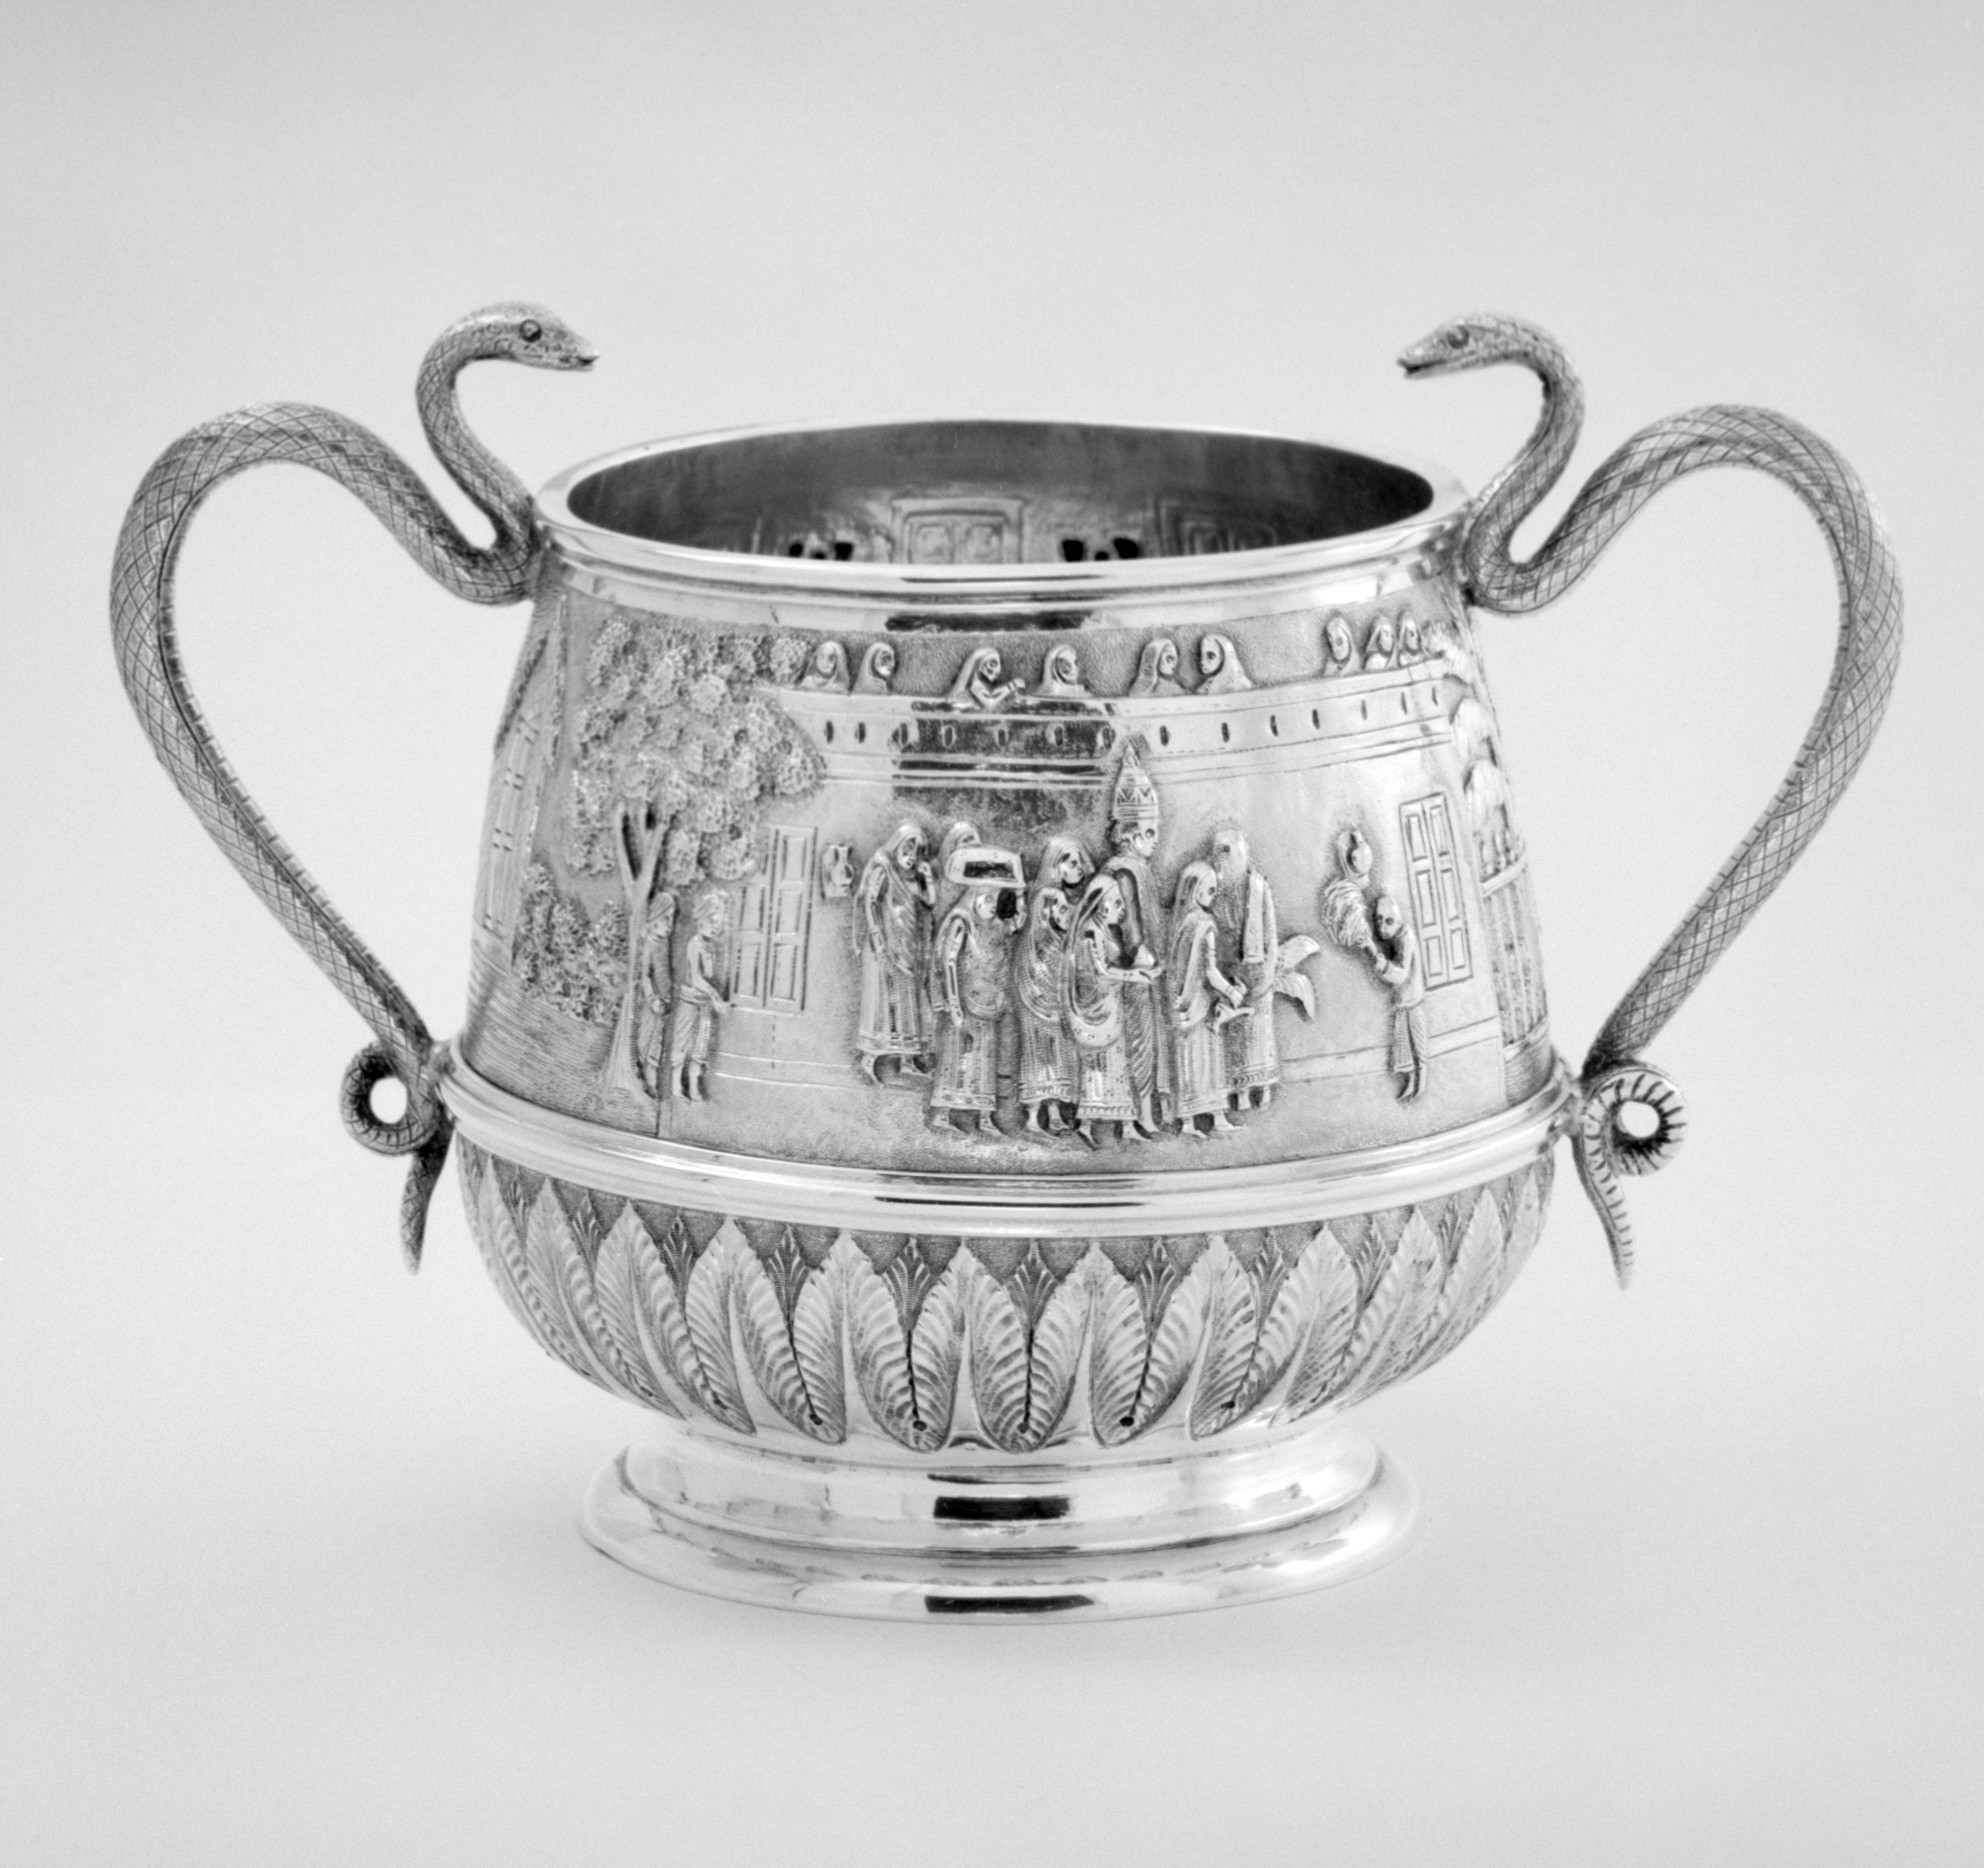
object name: sugar bowl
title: Sugar bowl (part of a set)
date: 1860-1880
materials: silver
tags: men,snakes